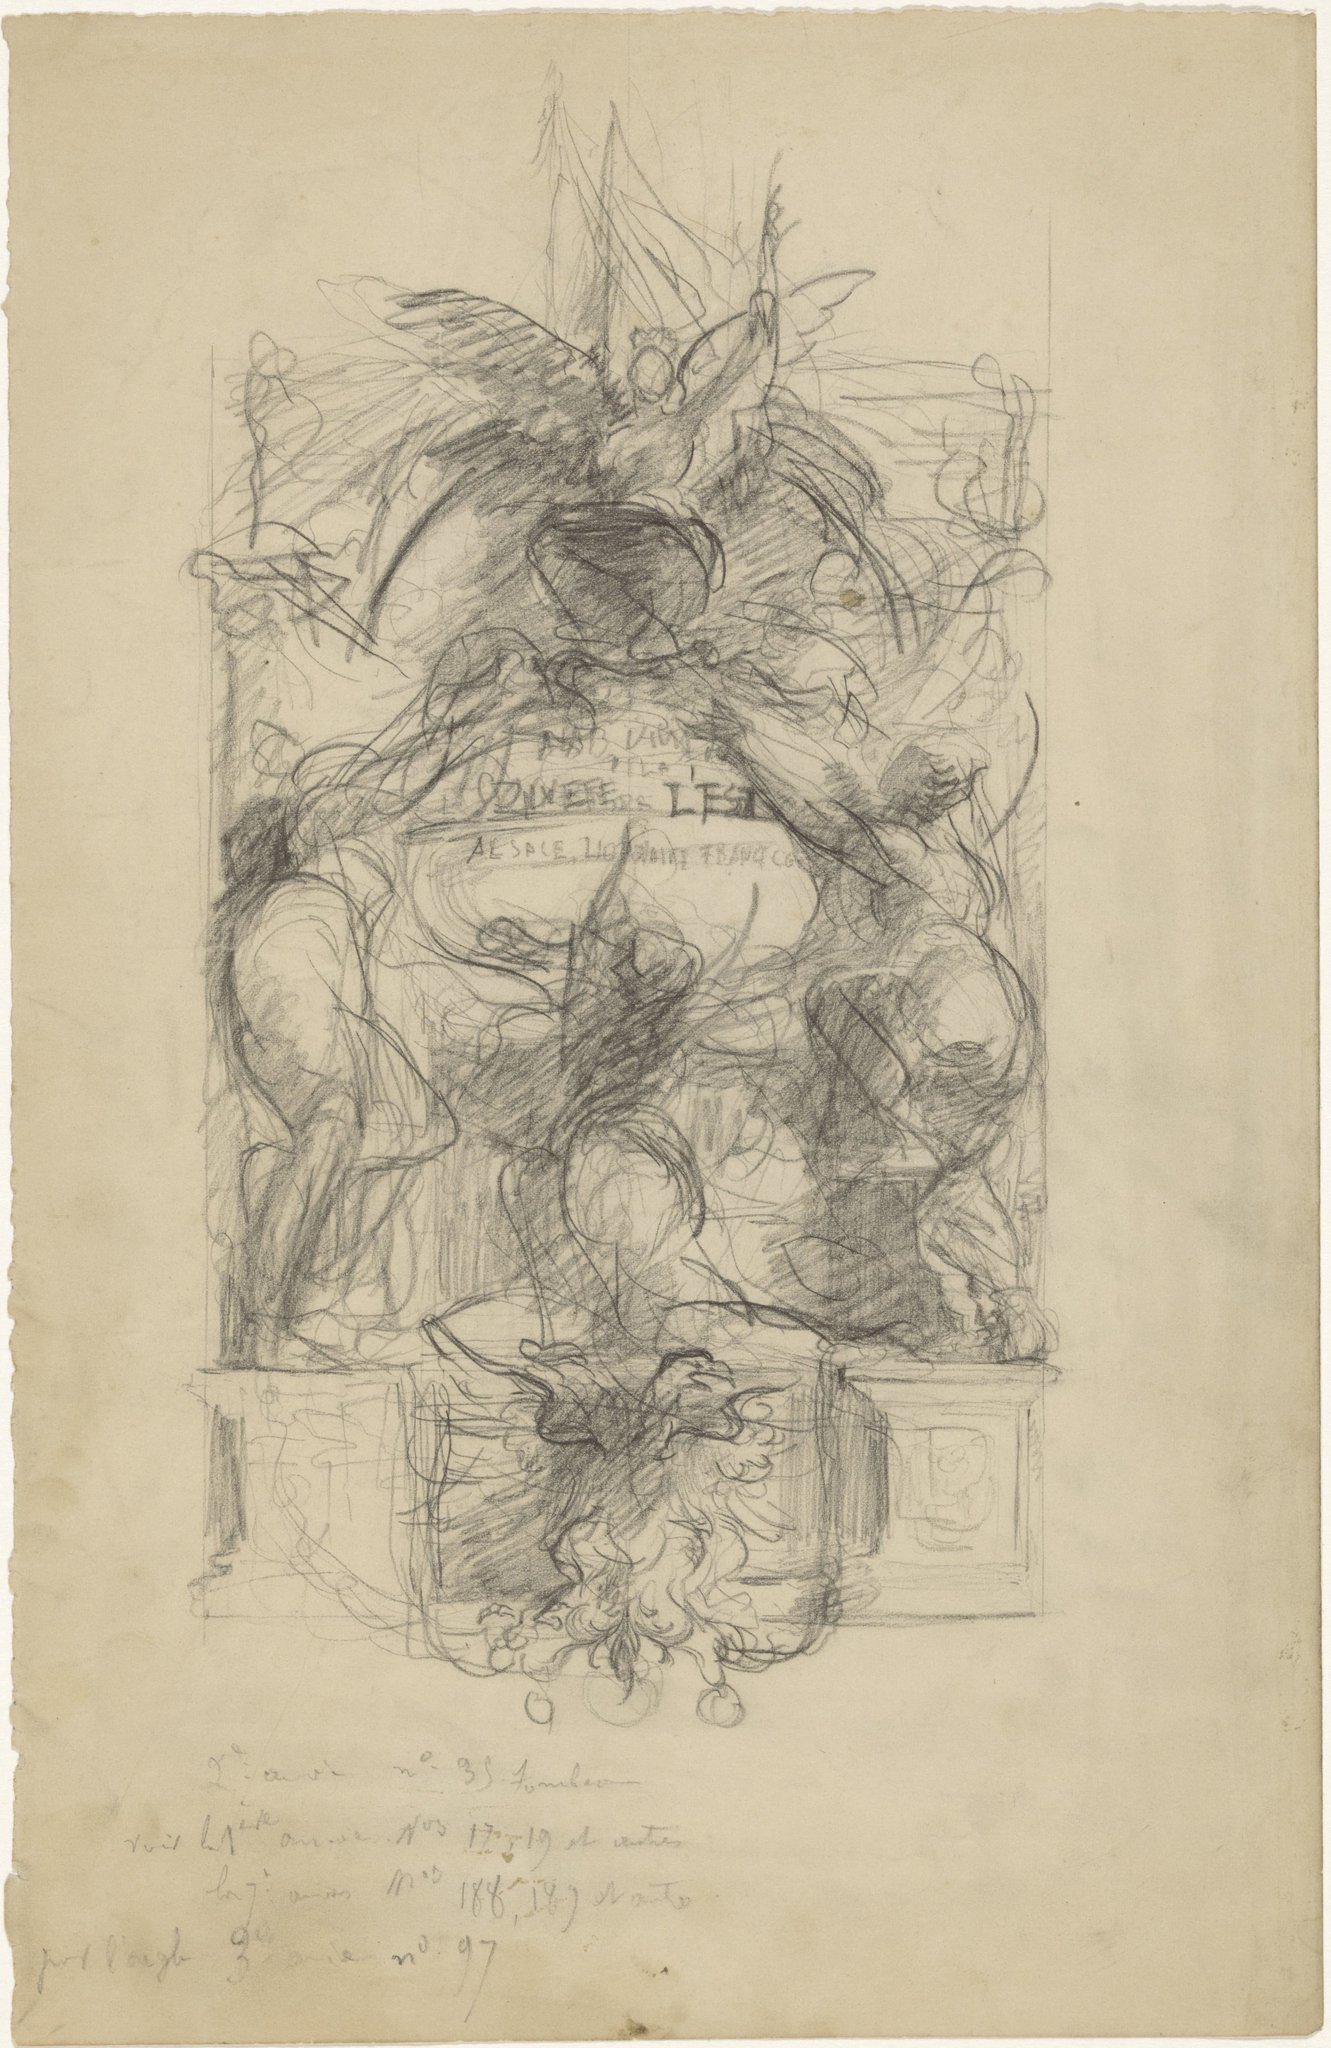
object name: drawing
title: Ontwerptekening allegorische groep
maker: emile boilvin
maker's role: print maker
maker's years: 1845-1899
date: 1855-1899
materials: chalk, paper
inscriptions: signature: ‘"E Boilvin" en "JF"’, annotation: ‘annotaties’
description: Ontwerptekening allegorische groep (voor beeldhouwwerk?).